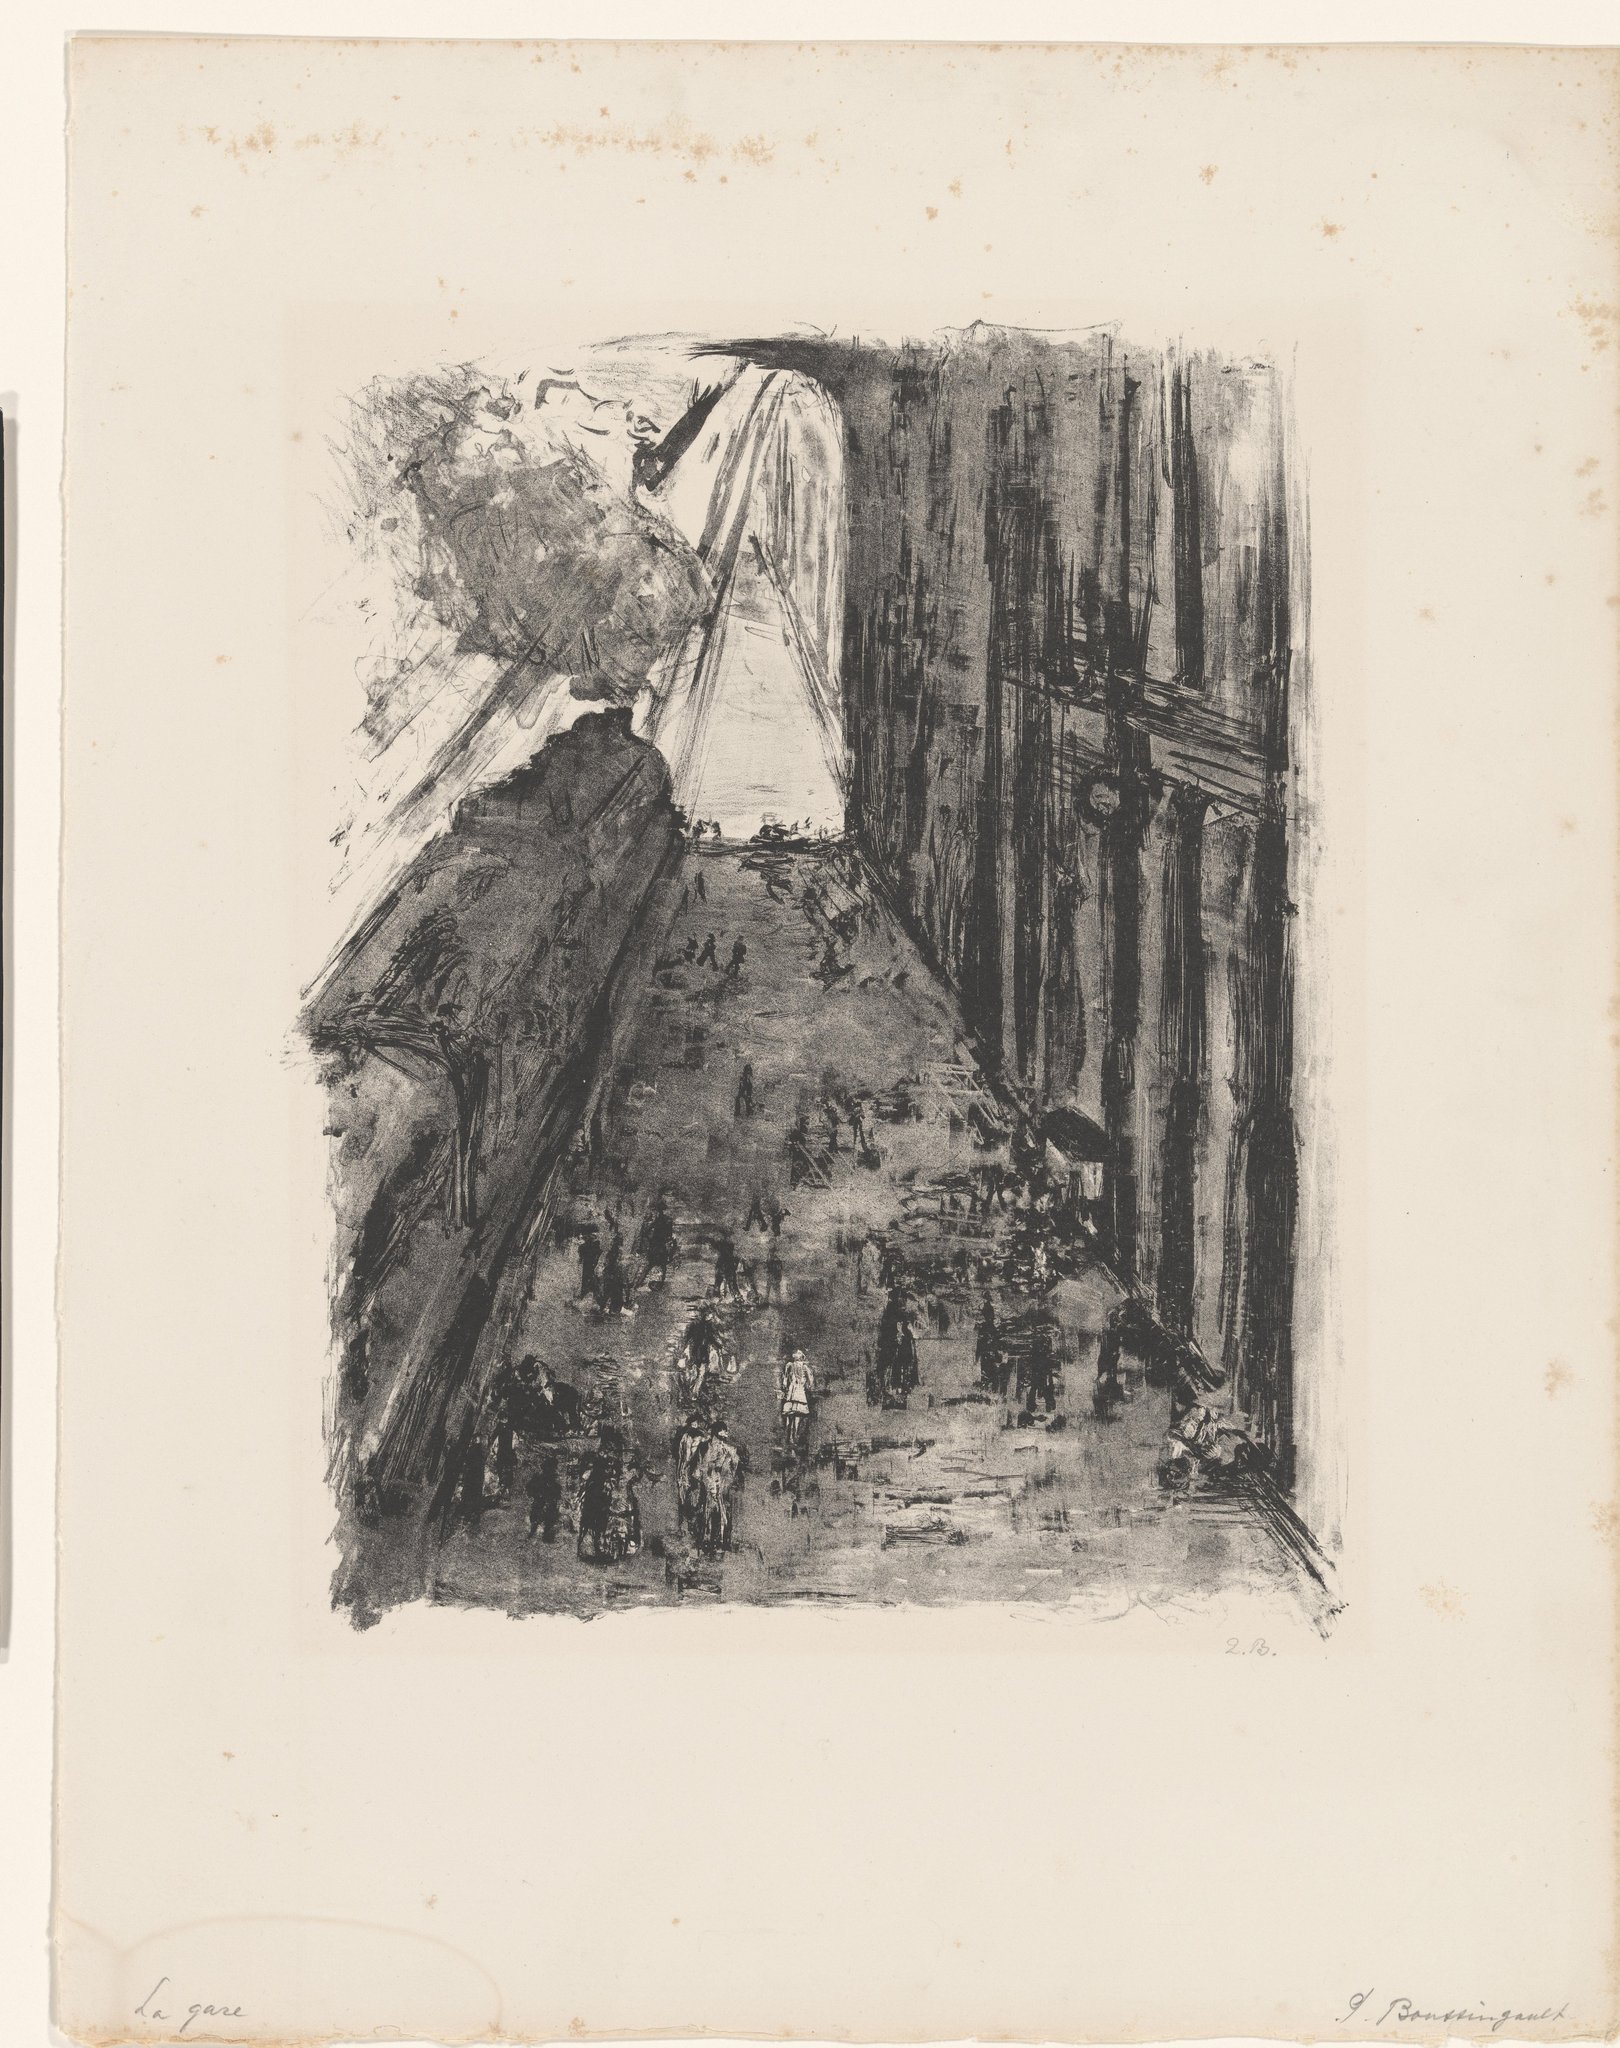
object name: print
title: La Gare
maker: jean-louis boussingault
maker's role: painter, print maker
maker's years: 1883-1943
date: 1893-1943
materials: paper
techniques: lithograph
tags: platform (railway, tramway)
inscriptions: collector's mark: Lugt 2228